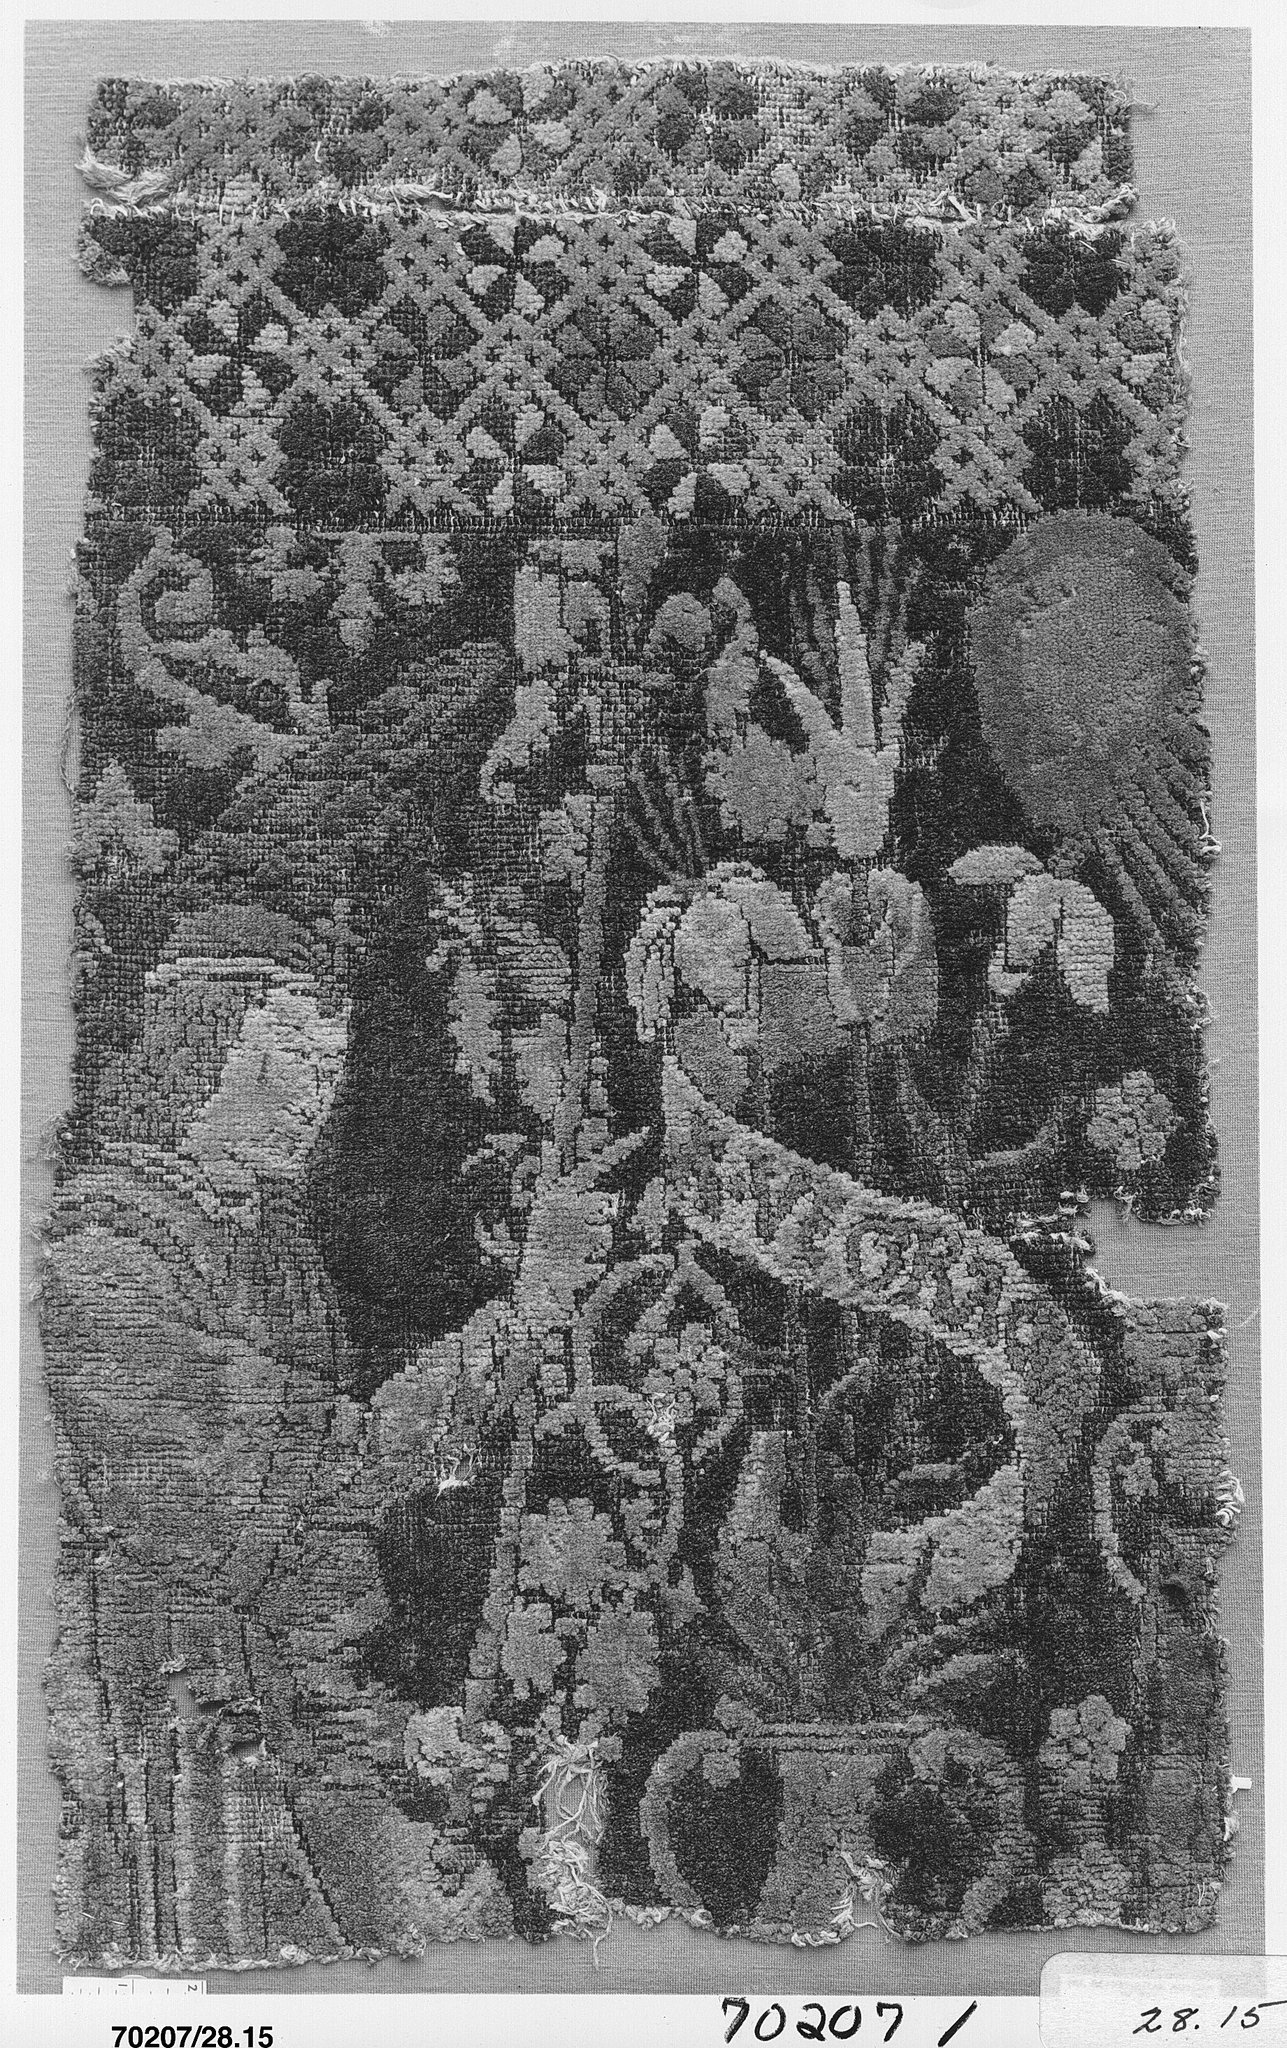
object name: rug or hanging fragment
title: Fragment of a rug or hanging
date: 1467-1533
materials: wool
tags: men,flowers